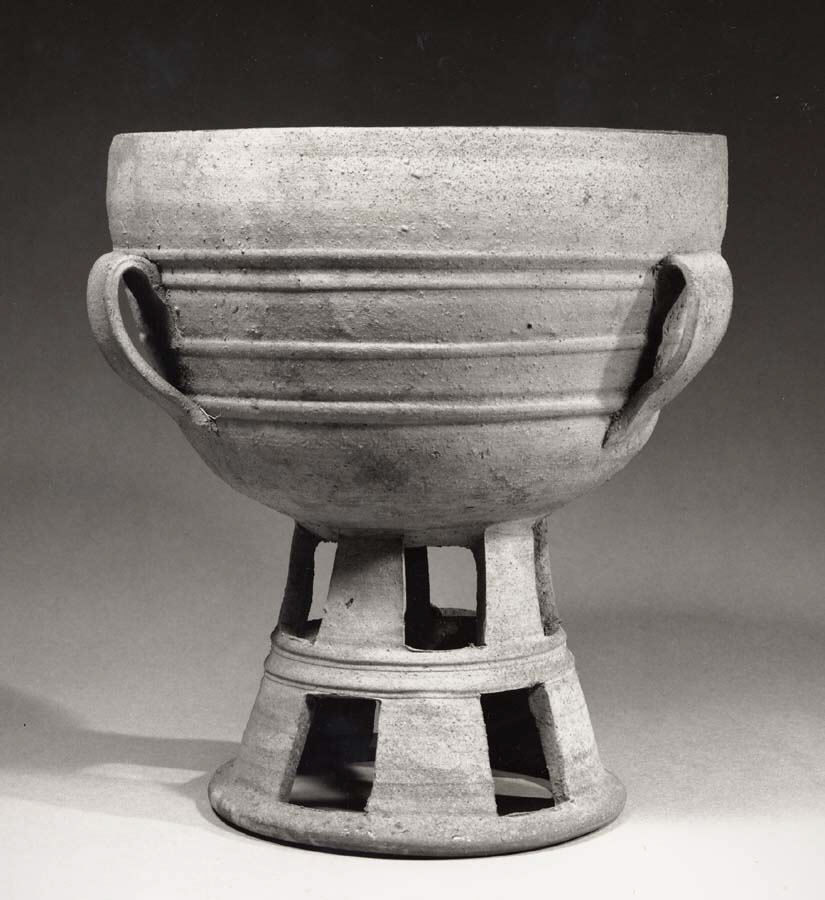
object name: pedestal bowl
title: Pedestal bowl with handles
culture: korean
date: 401-500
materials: pottery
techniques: firing